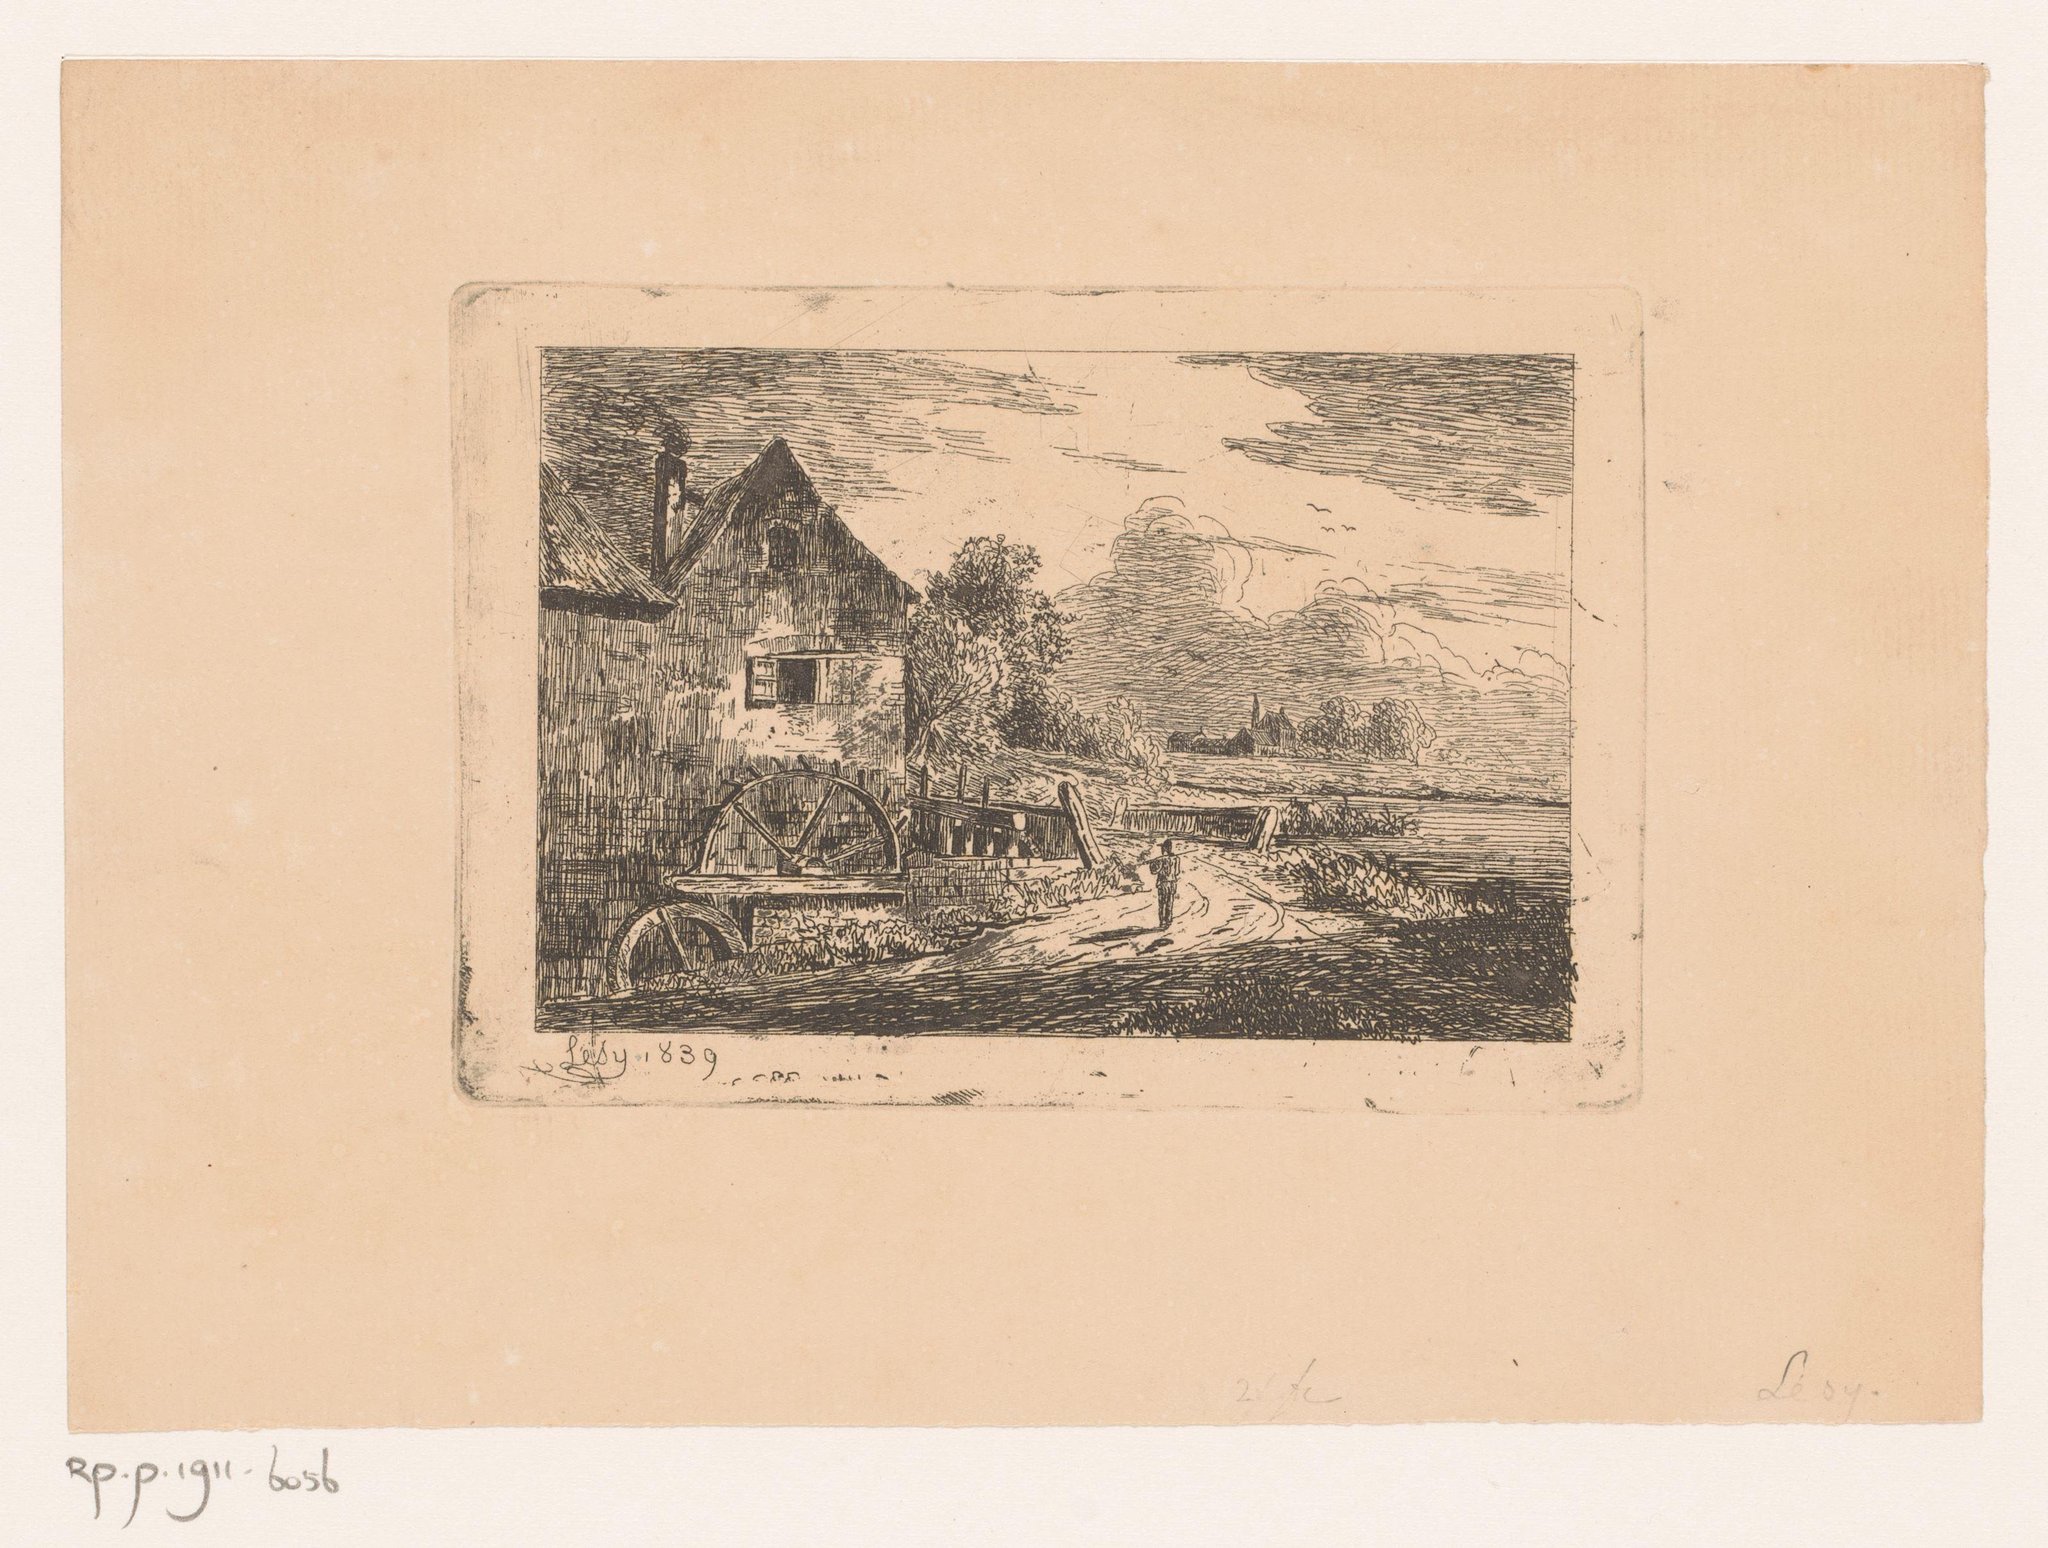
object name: print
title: Landschap met watermolen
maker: désiré lesy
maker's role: print maker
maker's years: 1806-1859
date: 1839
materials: paper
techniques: etching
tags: watermill in landscape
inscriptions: collector's mark: Lugt 2228